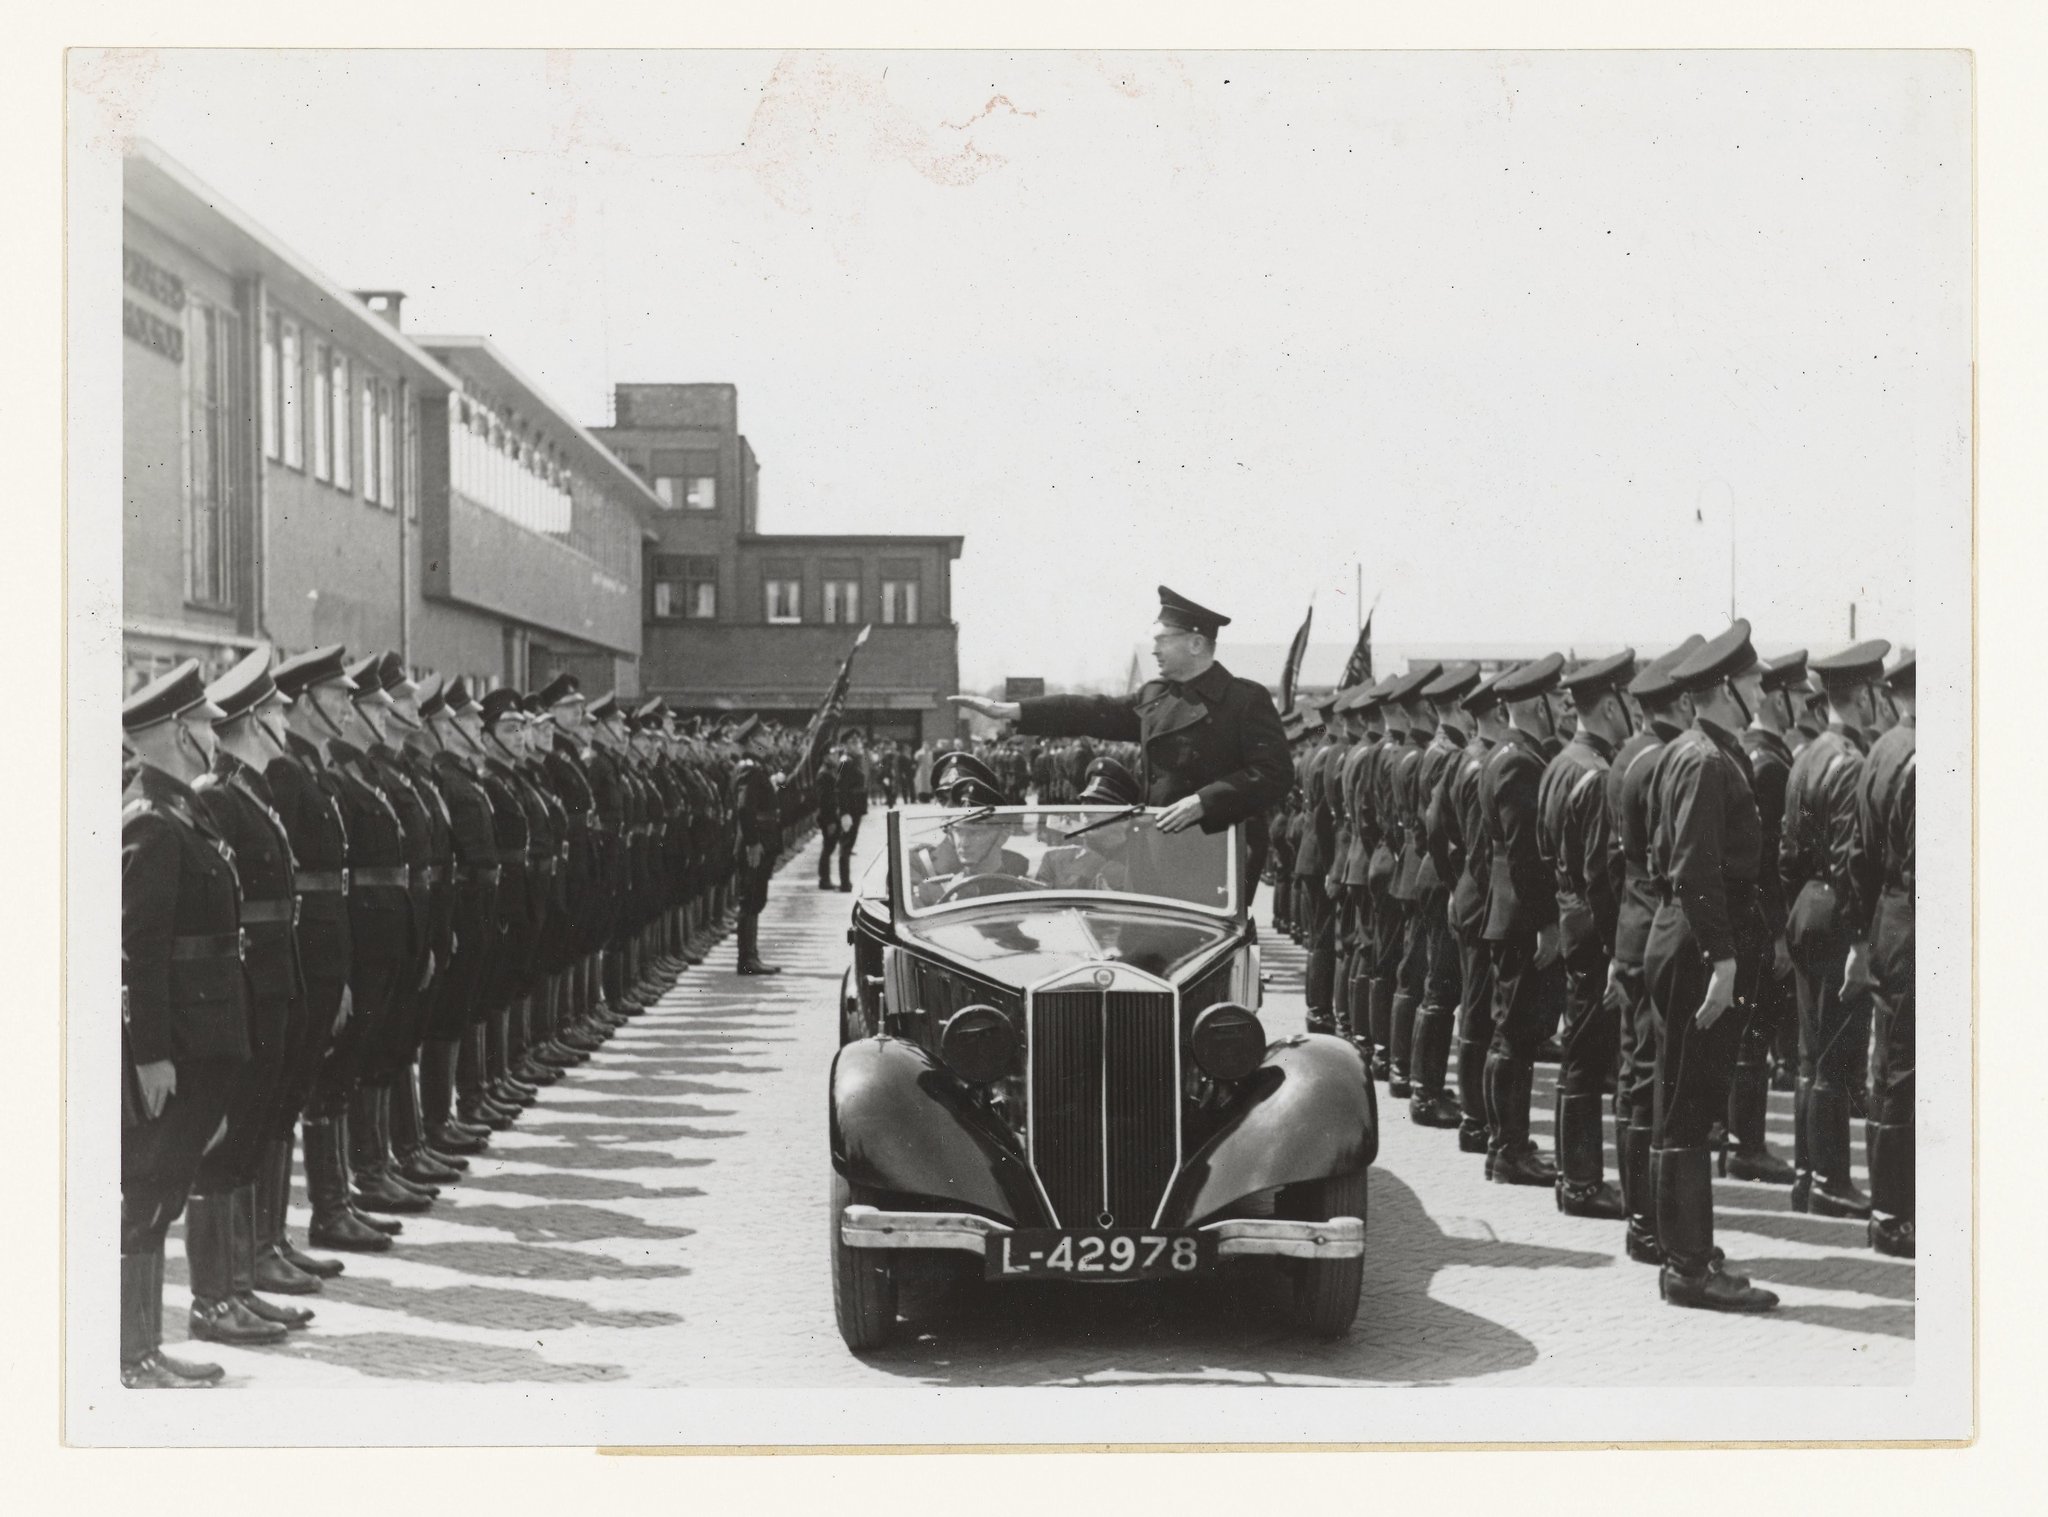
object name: photograph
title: Inspectie door Anton Mussert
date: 1941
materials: photographic support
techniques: gelatin silver print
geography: utrecht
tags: the hague, politician, anton adriaan mussert, military parade, pageant, utrecht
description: Op zijn verjaardag op 11 mei 1941 inspecteert Anton Mussert zijn troepen vanuit een auto. Opgesteld langs de kant van de weg staan: WA, Nederlandse SS en (niet zichtbaar) de Jeugdstorm. Mussert brengt hen de NSB groet.